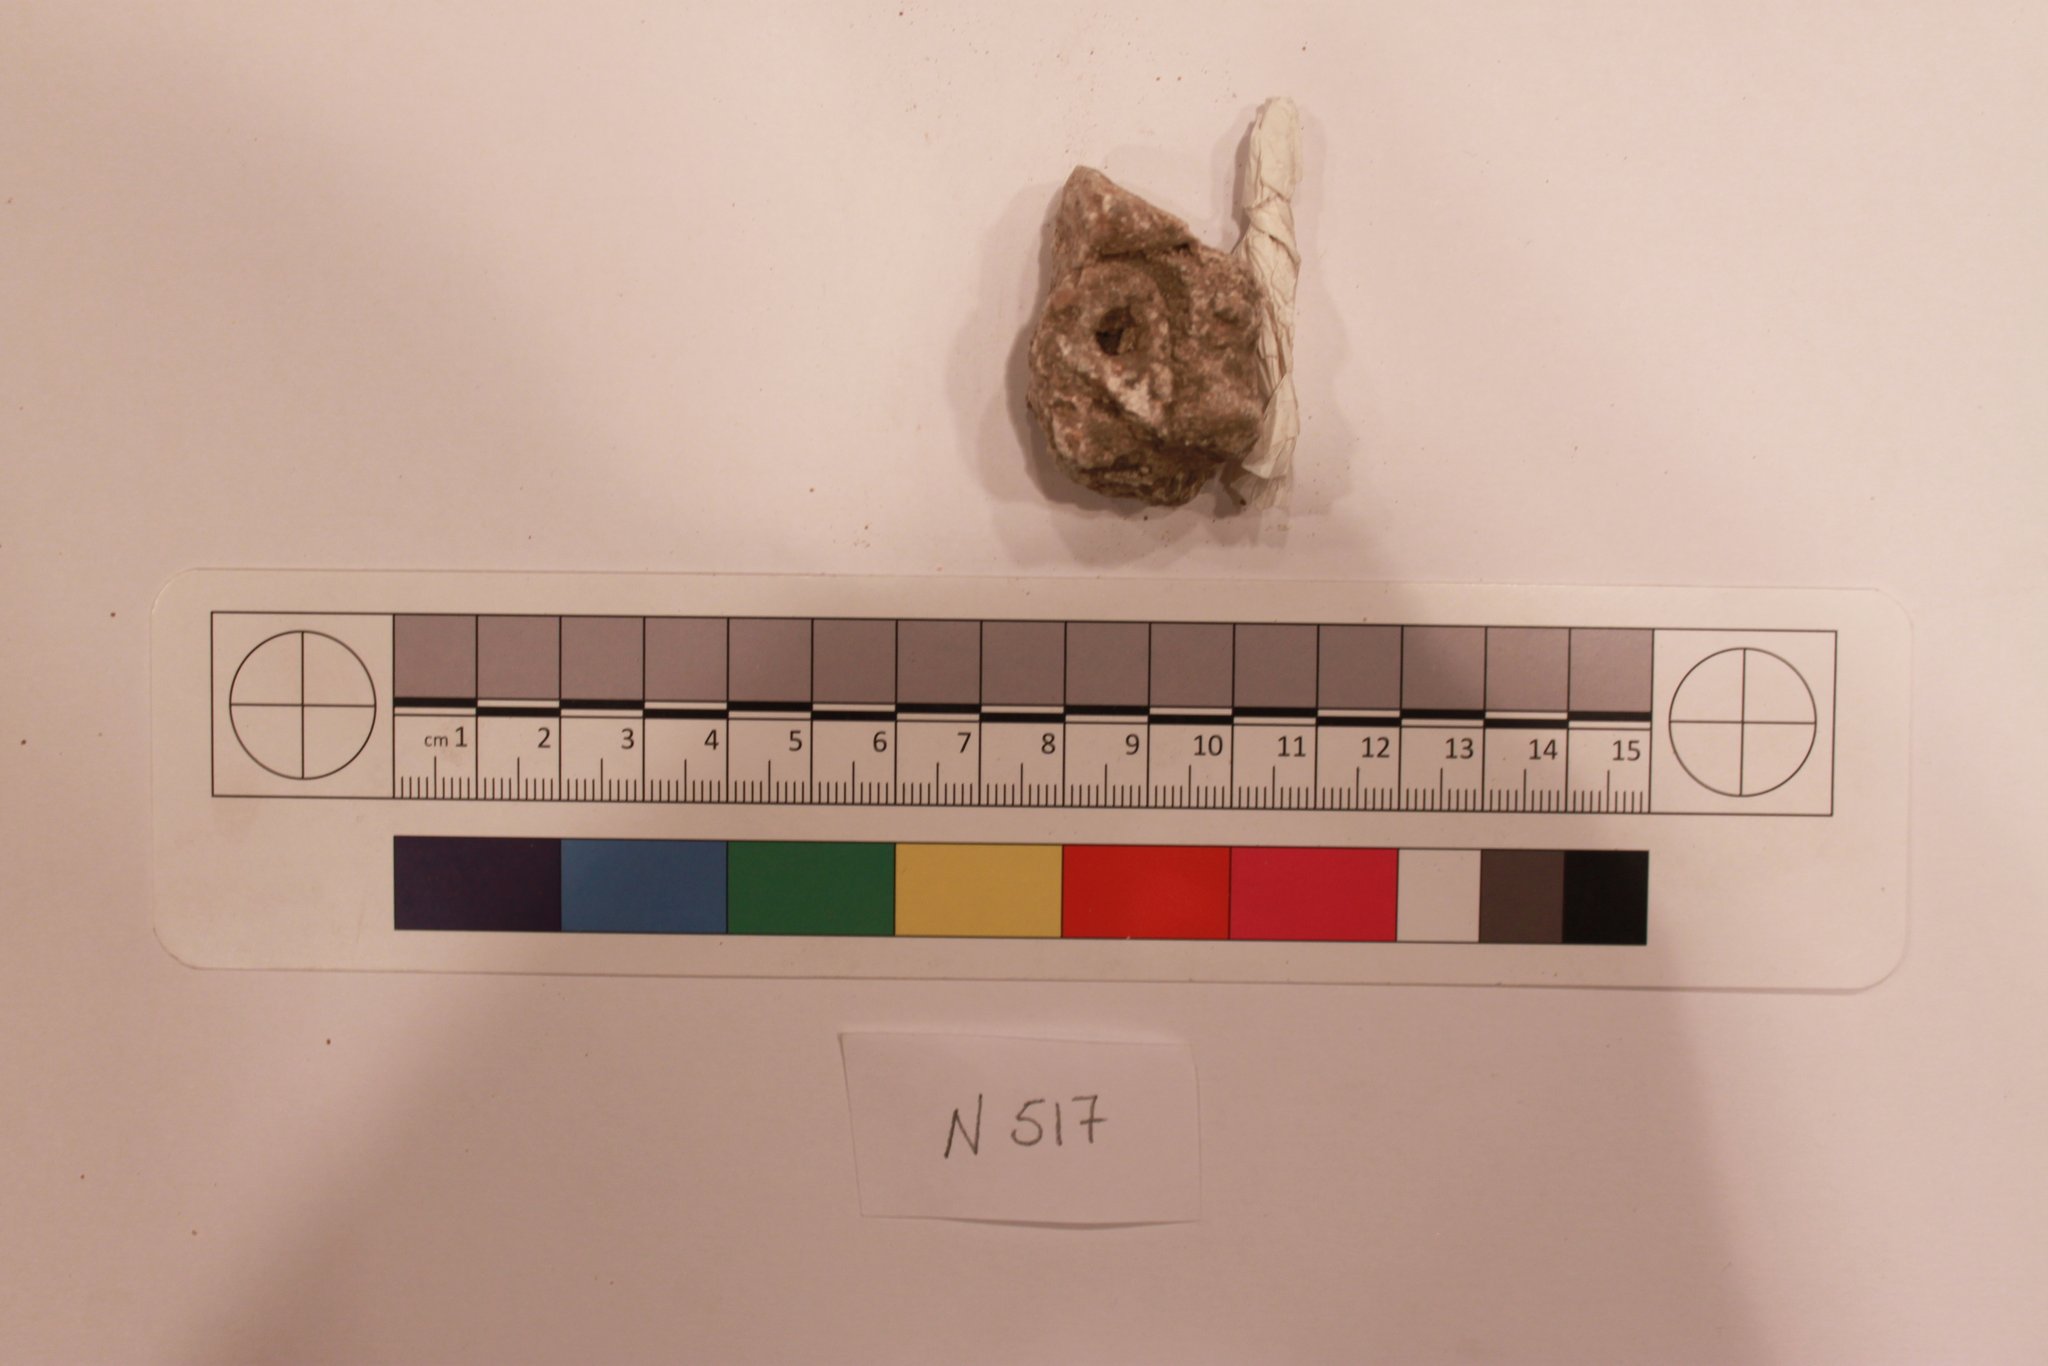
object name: fragment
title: Stucco Fragment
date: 701-1200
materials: plaster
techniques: carving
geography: iran